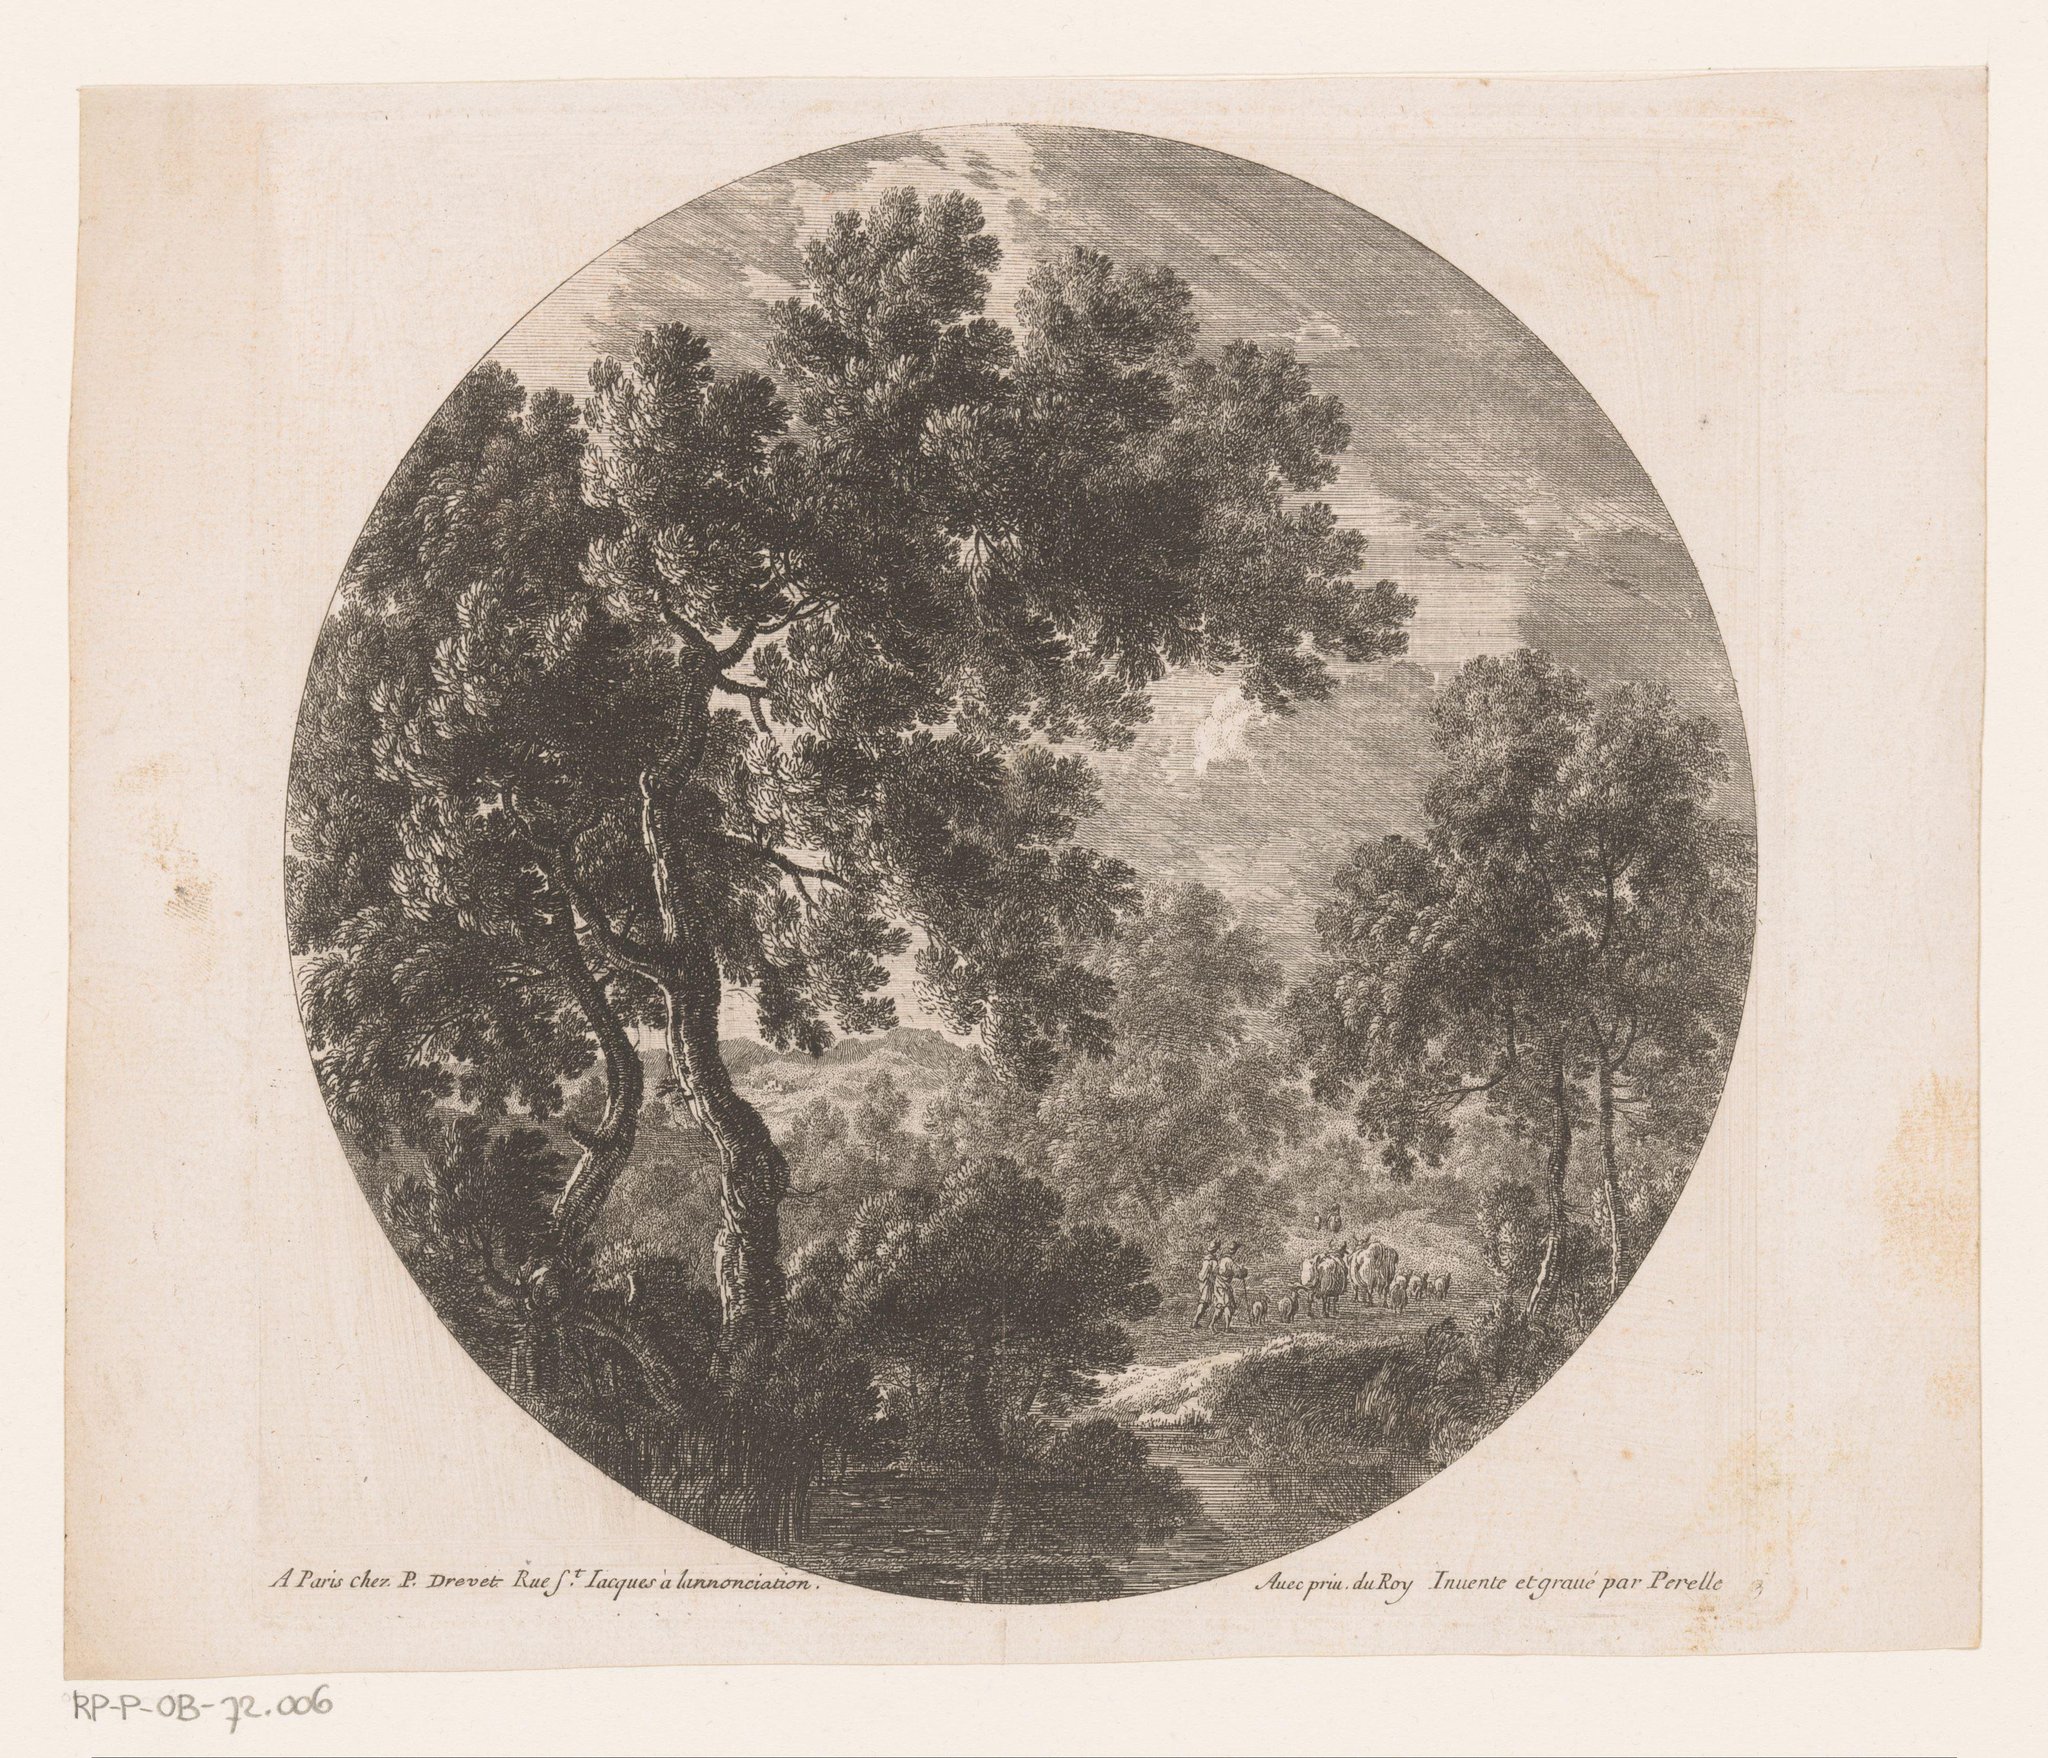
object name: print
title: Boslandschap met twee mannen achter kudde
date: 1673-1695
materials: paper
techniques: etching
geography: paris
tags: forest, wood (+ landscape with figures, staffage), herd, flock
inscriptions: collector's mark: Lugt 240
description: Prenten met het signatuur 'Perelle' kunnen zowel door vader Gabriel als door zonen Nicolas en Adam gemaakt zijn.